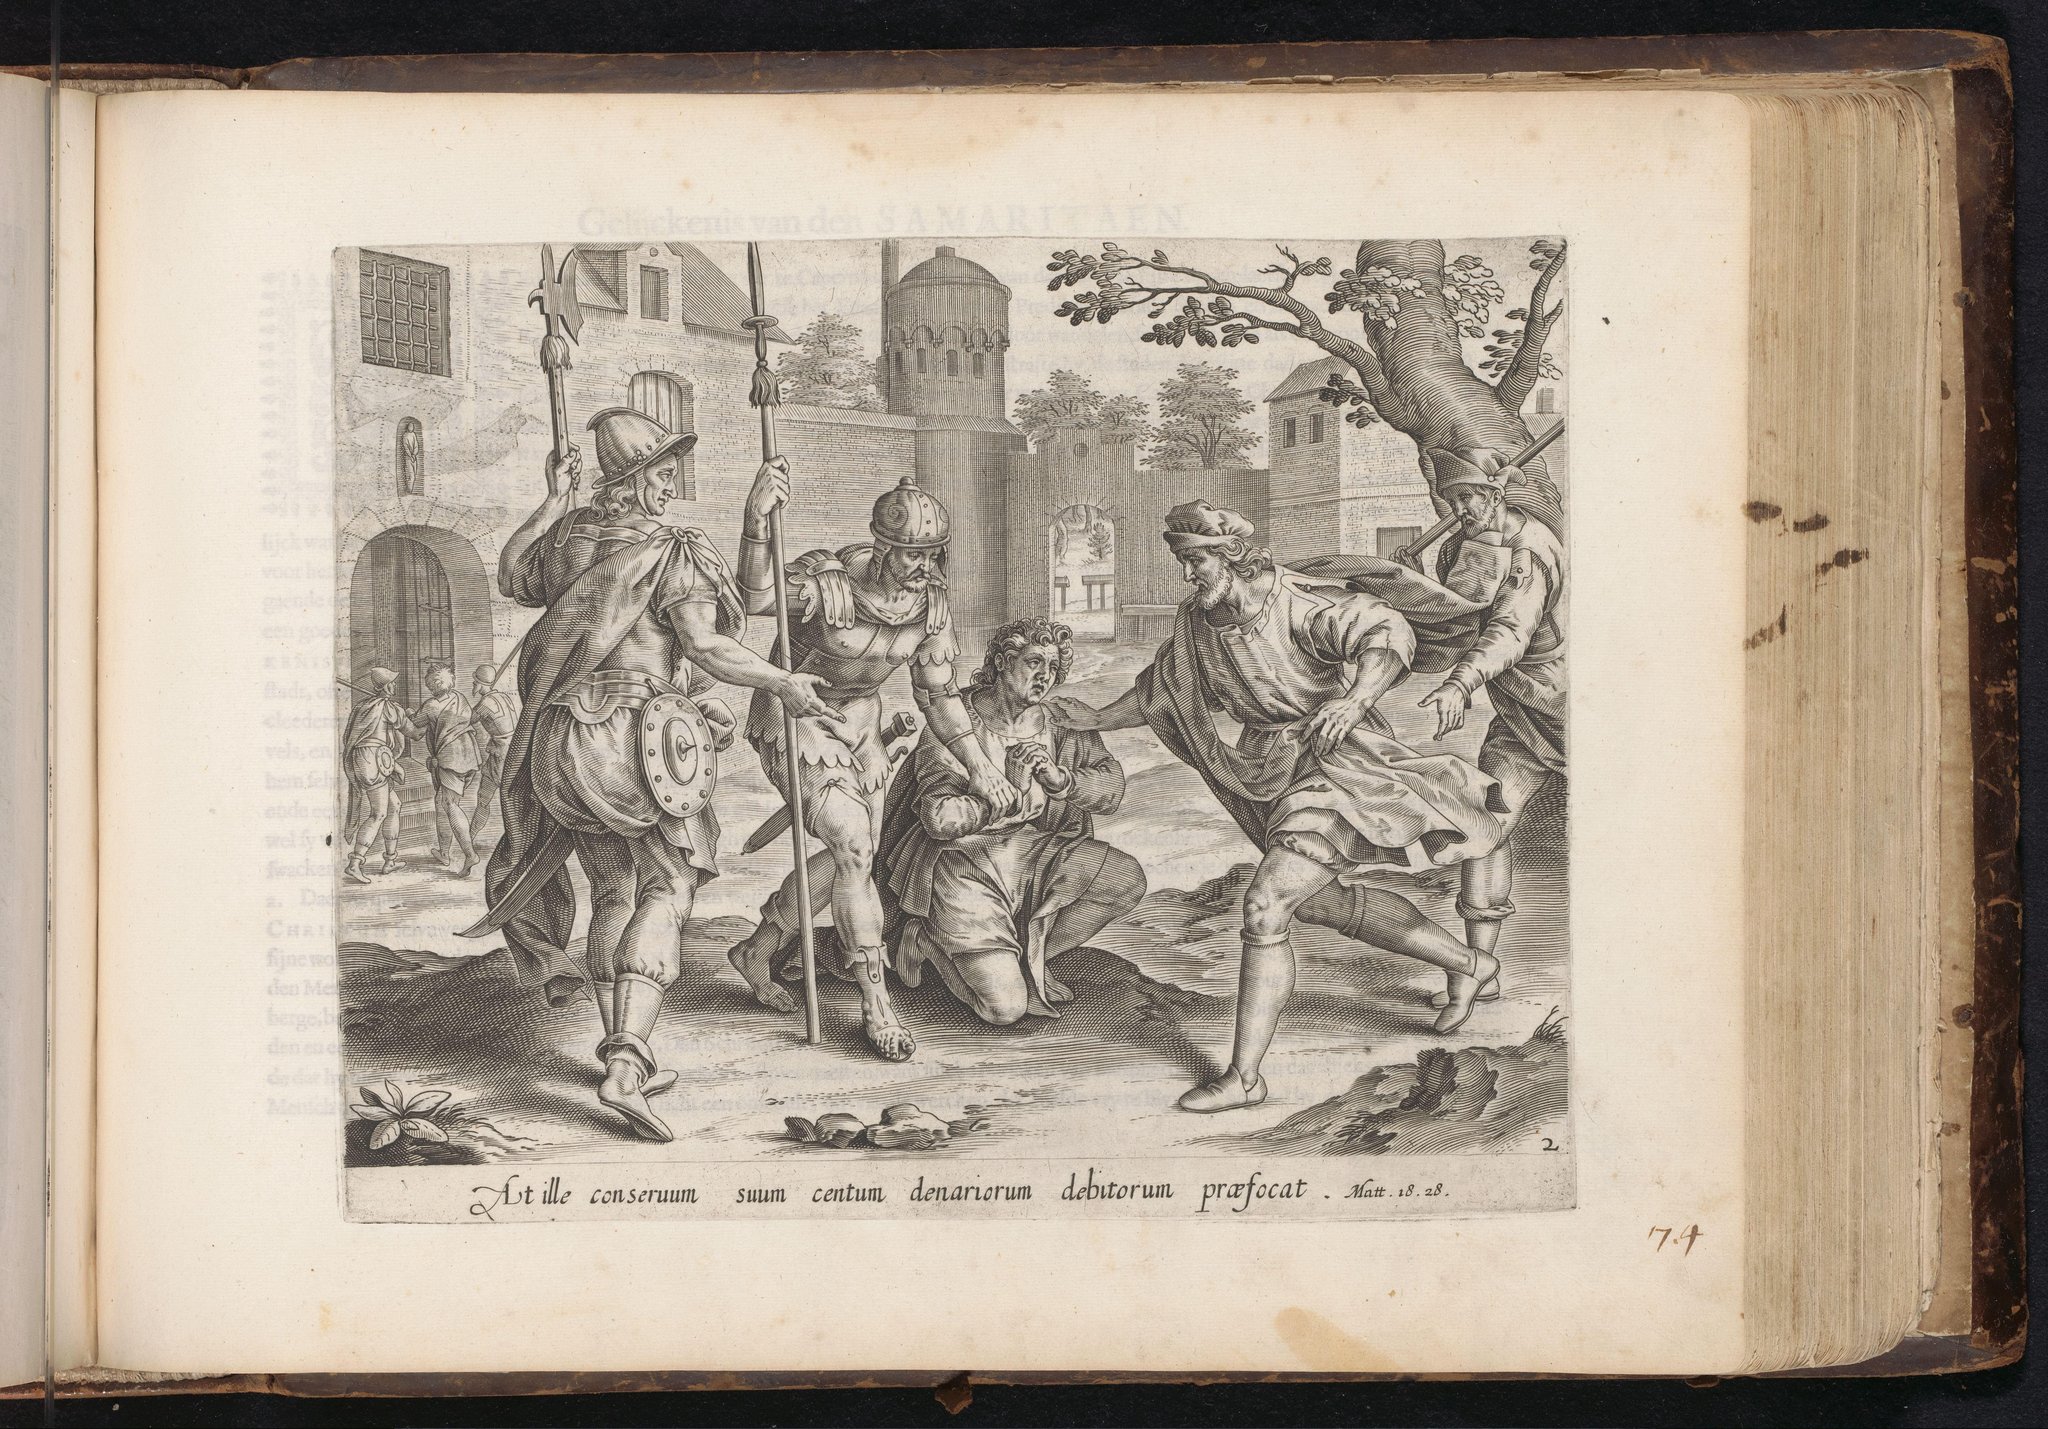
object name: album leaf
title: Ghelijkckenis van den Schuldigen Knecht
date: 1585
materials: paper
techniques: engraving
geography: amsterdam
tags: the unmerciful servant attacks his fellow-servant who owes him money, and casts him into prison ~ parable of the unmerciful servant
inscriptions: number: ‘74’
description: De dienaar, wiens schulden zojuist door de koning zijn kwijtgescholden, ontmoet een andere dienaar die hem honderd denarie schuldig is en eist dit bedrag van hem op. De man knielt en smeekt om uitstel. Maar de onbarmhartige dienaar geeft soldaten de opdracht om de man naar de gevangenis te brengen. Onder de voorstelling een verwijzing in het Latijn naar de Bijbeltekst in Mat. 18:28. Deze prent maakt deel uit van een album.